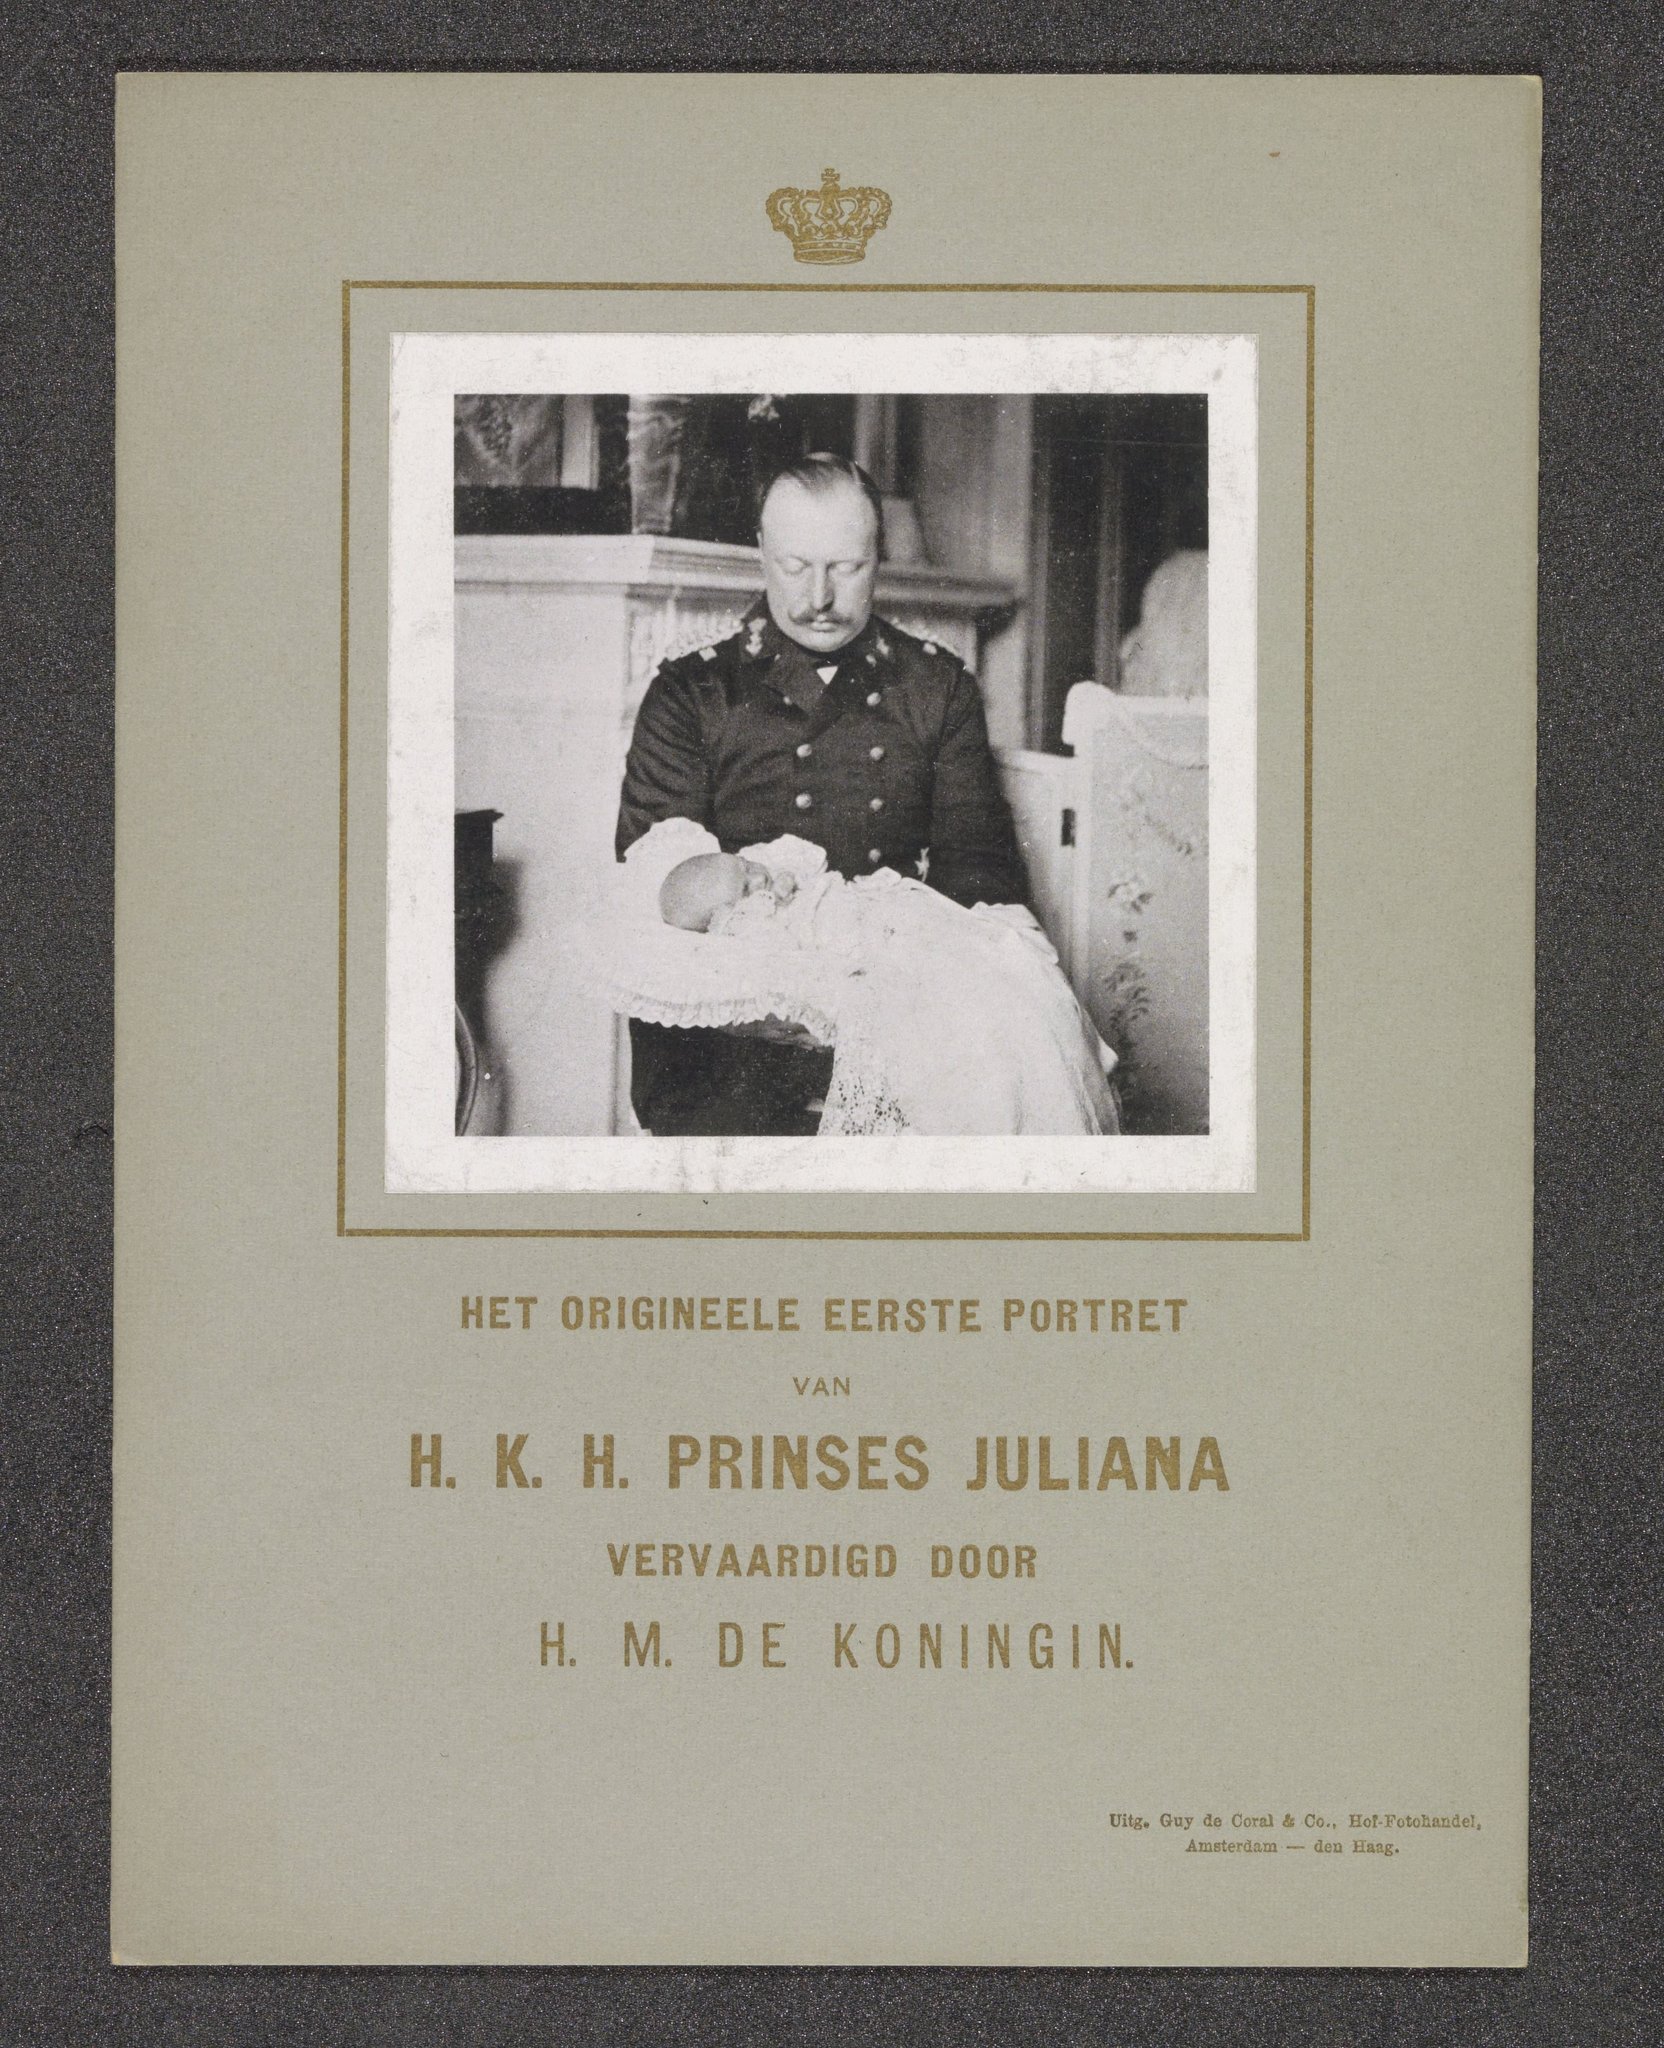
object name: photograph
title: Het origineele eerste portret van H.K.H. Prinses Juliana vervaardigd door H.M. de Koningin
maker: wilhelmina of the netherlands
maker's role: print maker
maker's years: 1880-1962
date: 1909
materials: cardboard, photographic support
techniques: photograph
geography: amsterdam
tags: the hague, hendrik (prins der nederlanden (1876-1934)), juliana of the netherlands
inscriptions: annotation: ‘Het origineele eerste portret van H.K.H. Prinses Juliana vervaardigd door H.M. de Koningin’, stamp: ‘uitg. Guy de Coral & Co., Hof.Fotohandel Amsterdam - Den Haag’